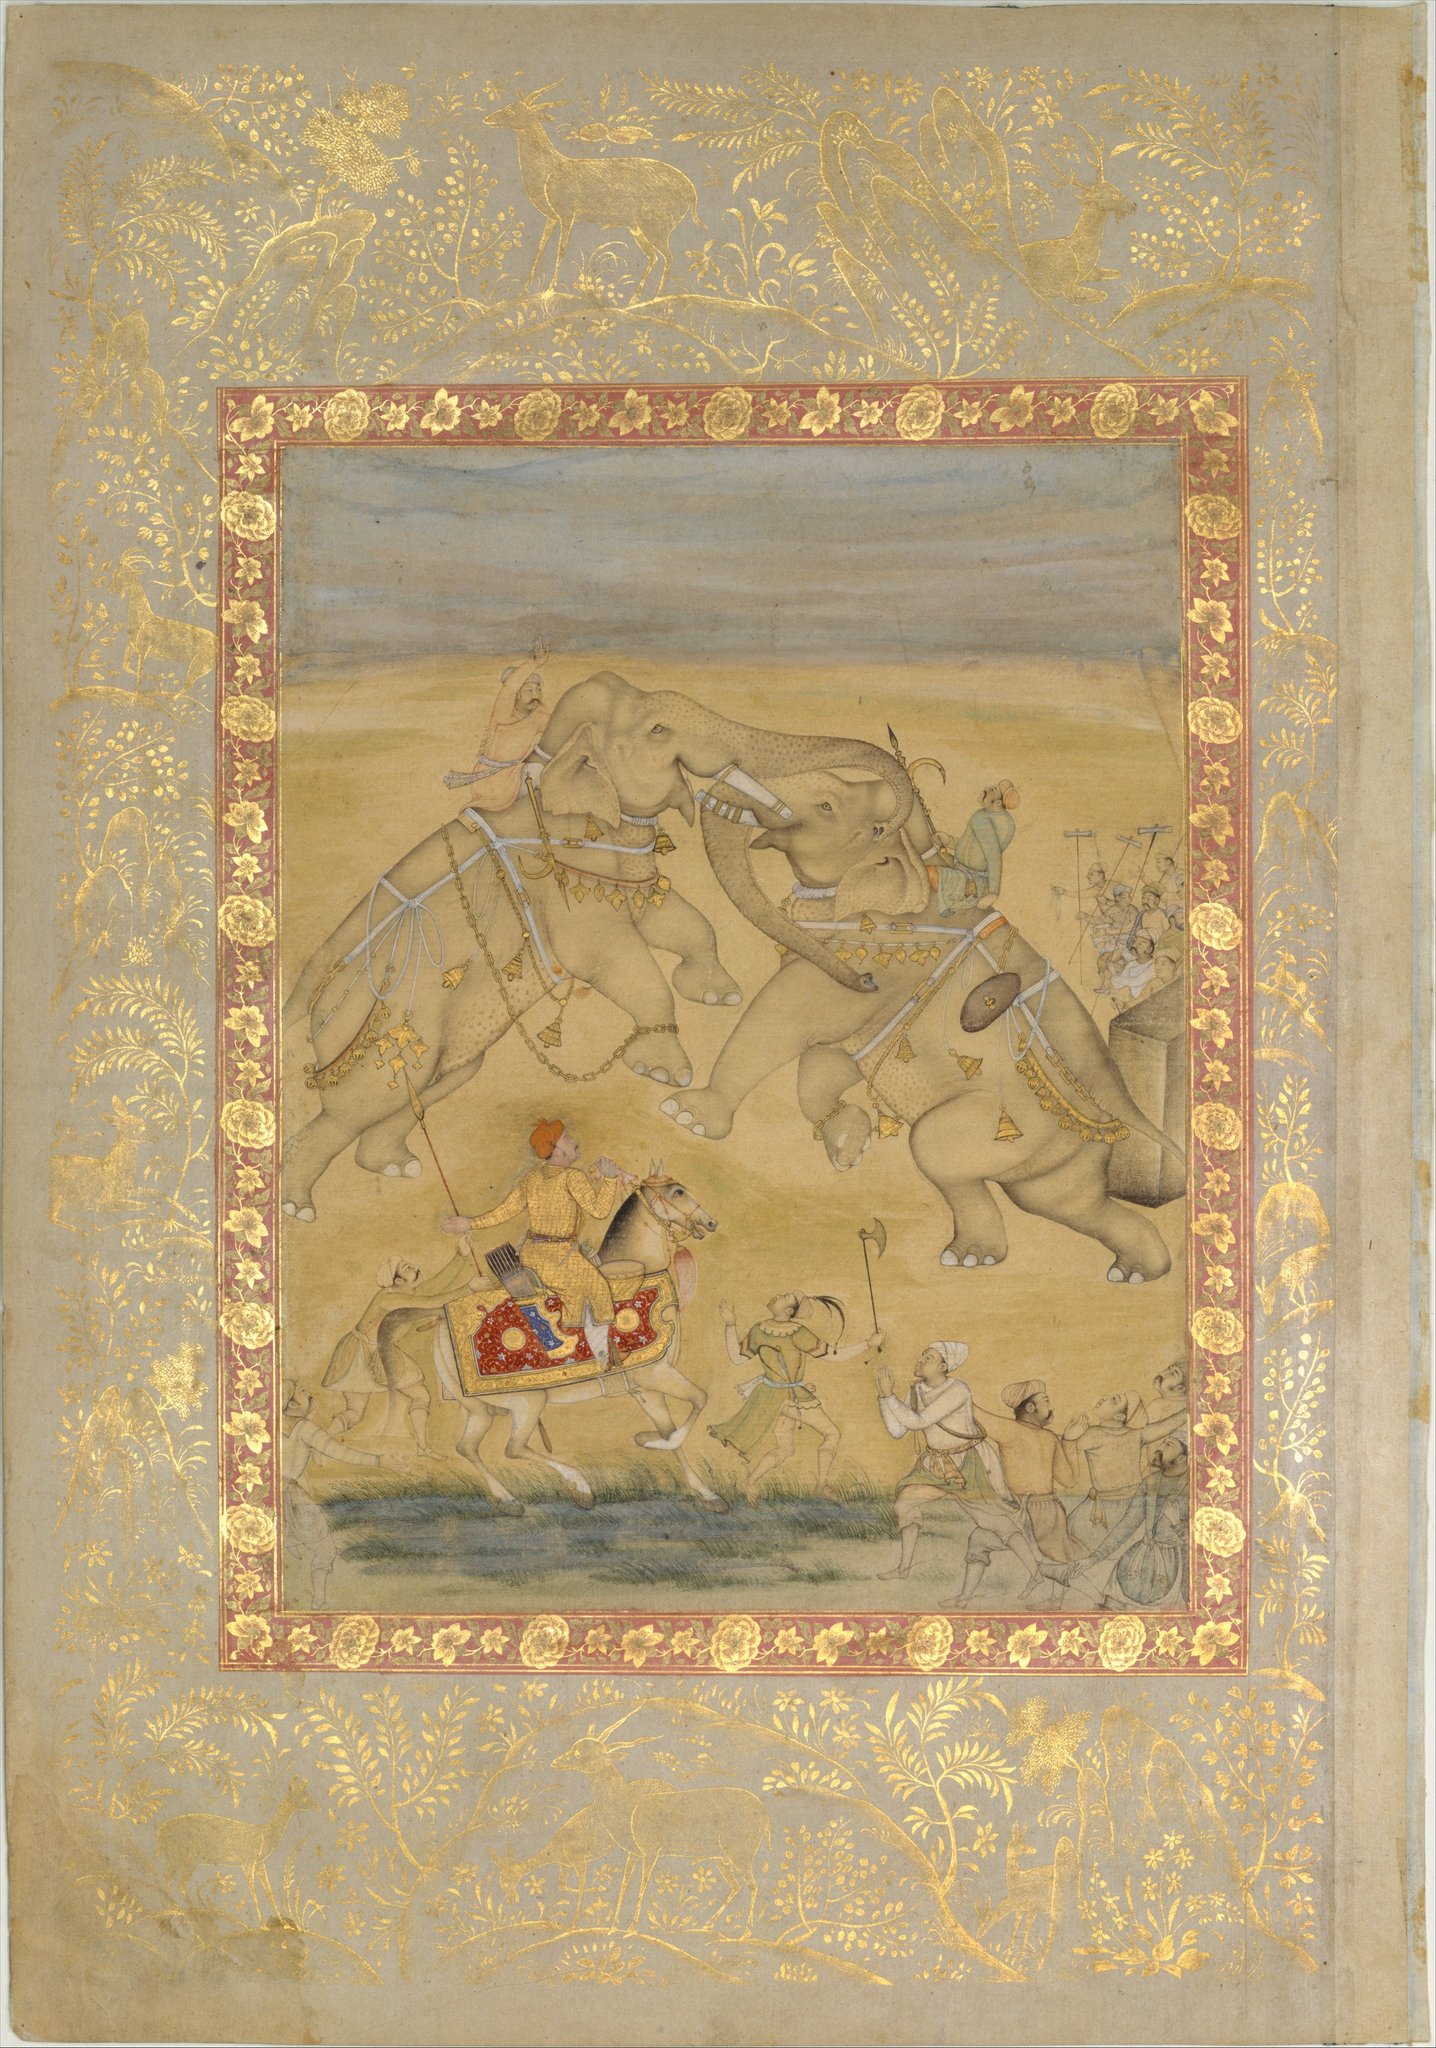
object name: illustrated single work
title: Jahangir Watching an Elephant Fight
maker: farrukh chela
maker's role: artist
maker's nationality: indian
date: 1605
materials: gold, ink, paper, watercolor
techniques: dyeing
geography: india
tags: men,elephants,horses